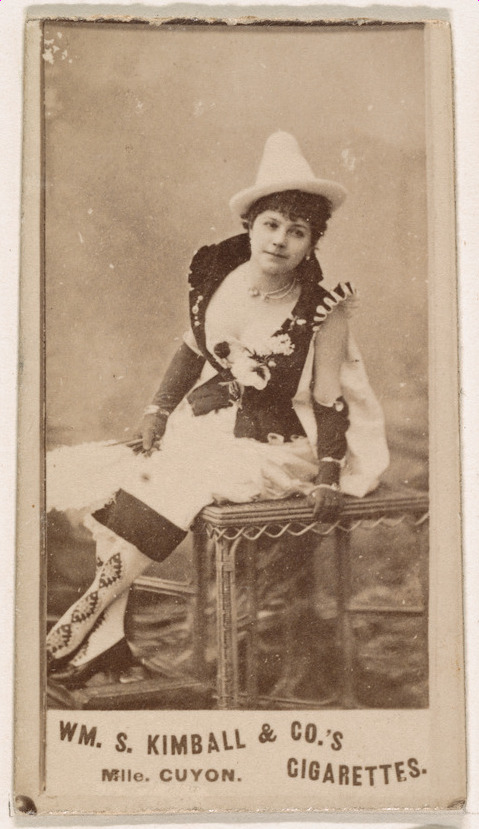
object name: photograph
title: Mlle. Cuyon, from the Actresses series (N203) issued by Wm. S. Kimball & Co.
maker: william s. kimball & company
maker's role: publisher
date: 1889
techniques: color lithograph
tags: portraits,women,actresses